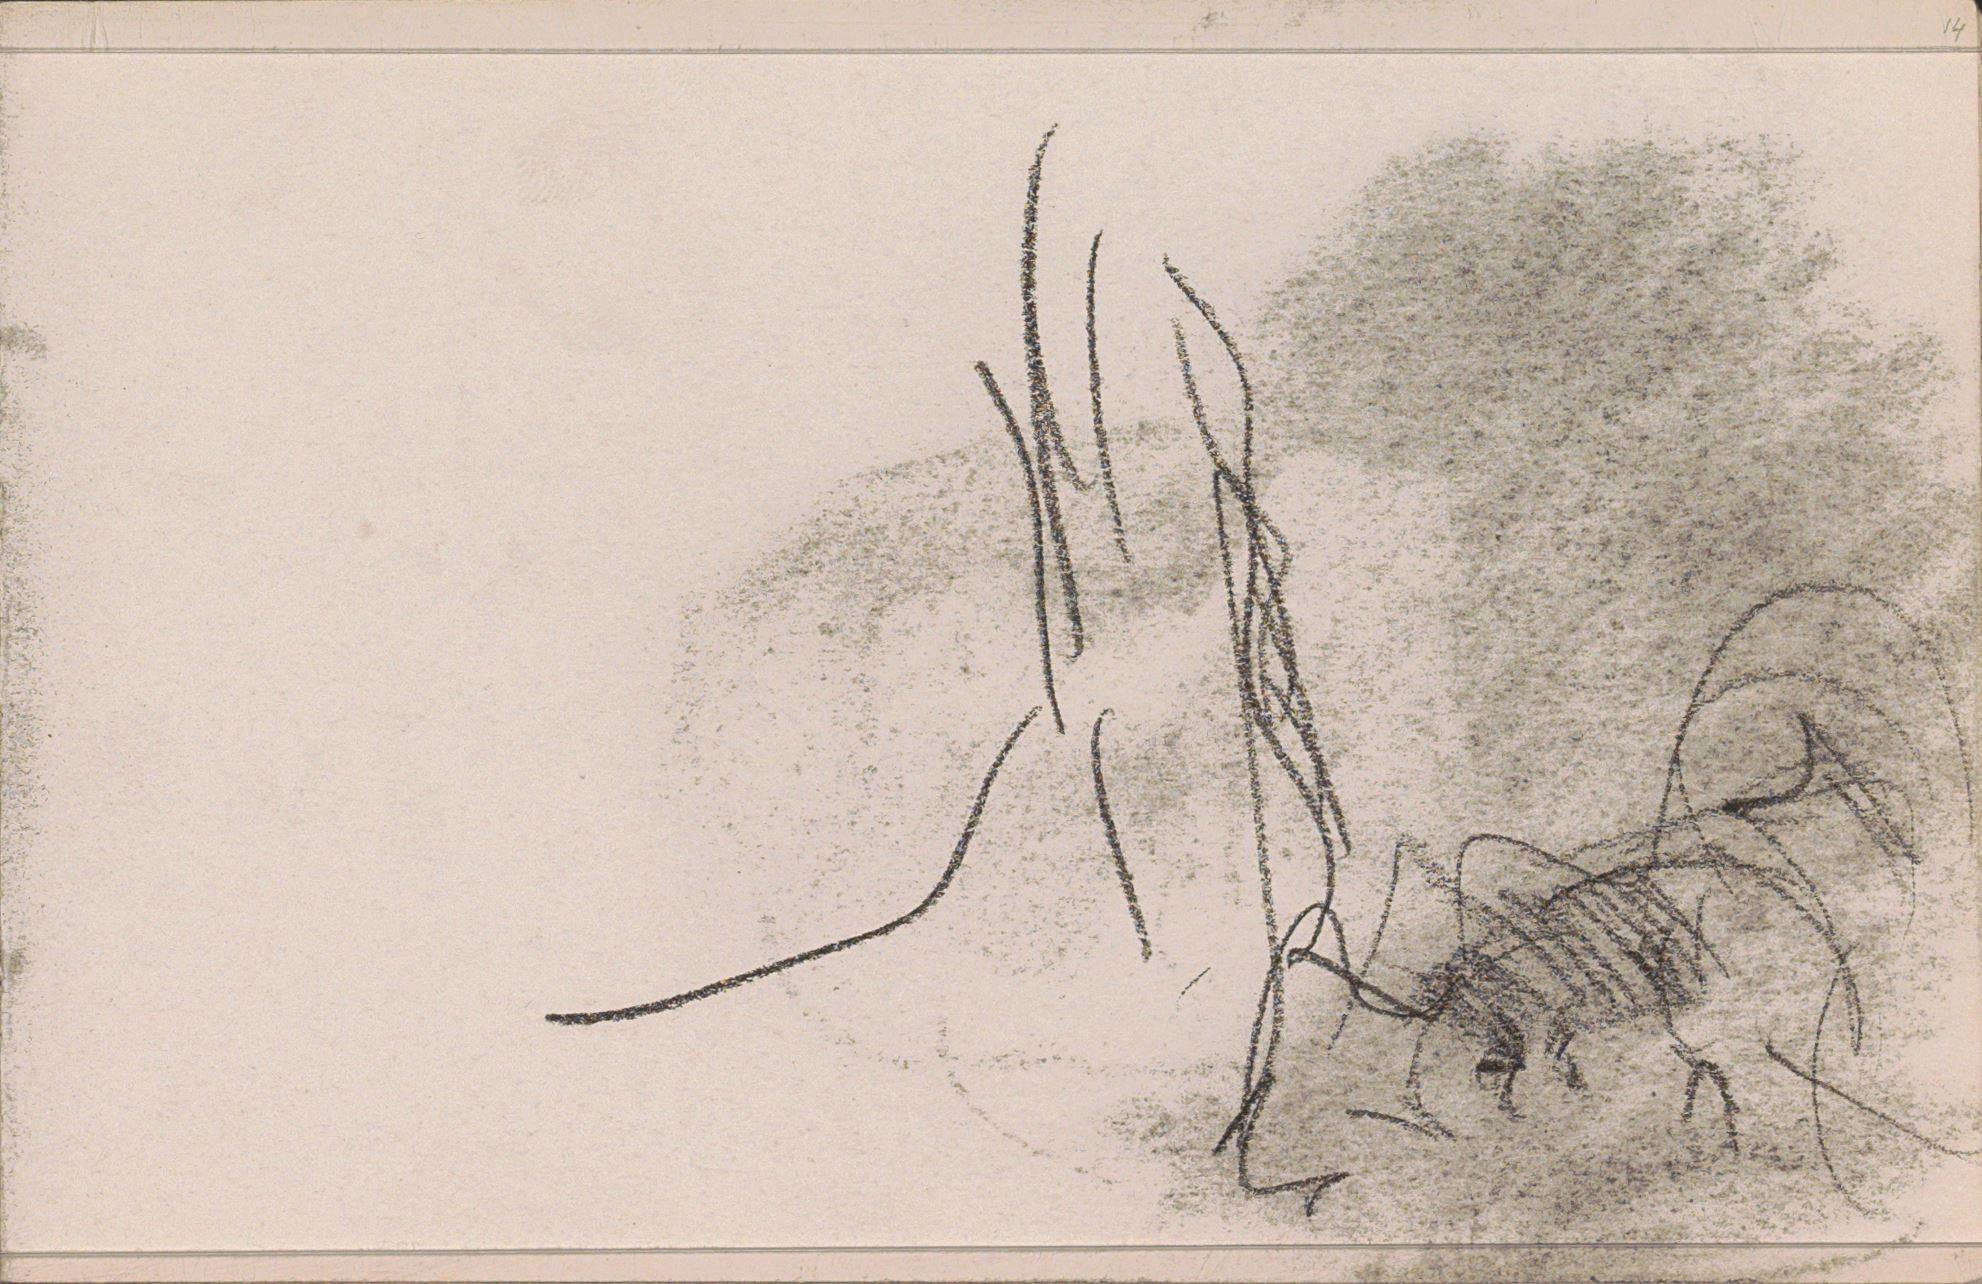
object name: sketchbook leaf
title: Vrouw met uitgestoken rechterarm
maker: isaac israels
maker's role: draughtsman, painter, print maker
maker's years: 1865-1934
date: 1887-1934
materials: chalk, paper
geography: paris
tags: adult woman, arm stretched sidewards, head-gear: hat (+ women's clothes)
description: Ze draagt een hoed. Pagina 14 uit schetsboek XLIX met 32 pagina's.